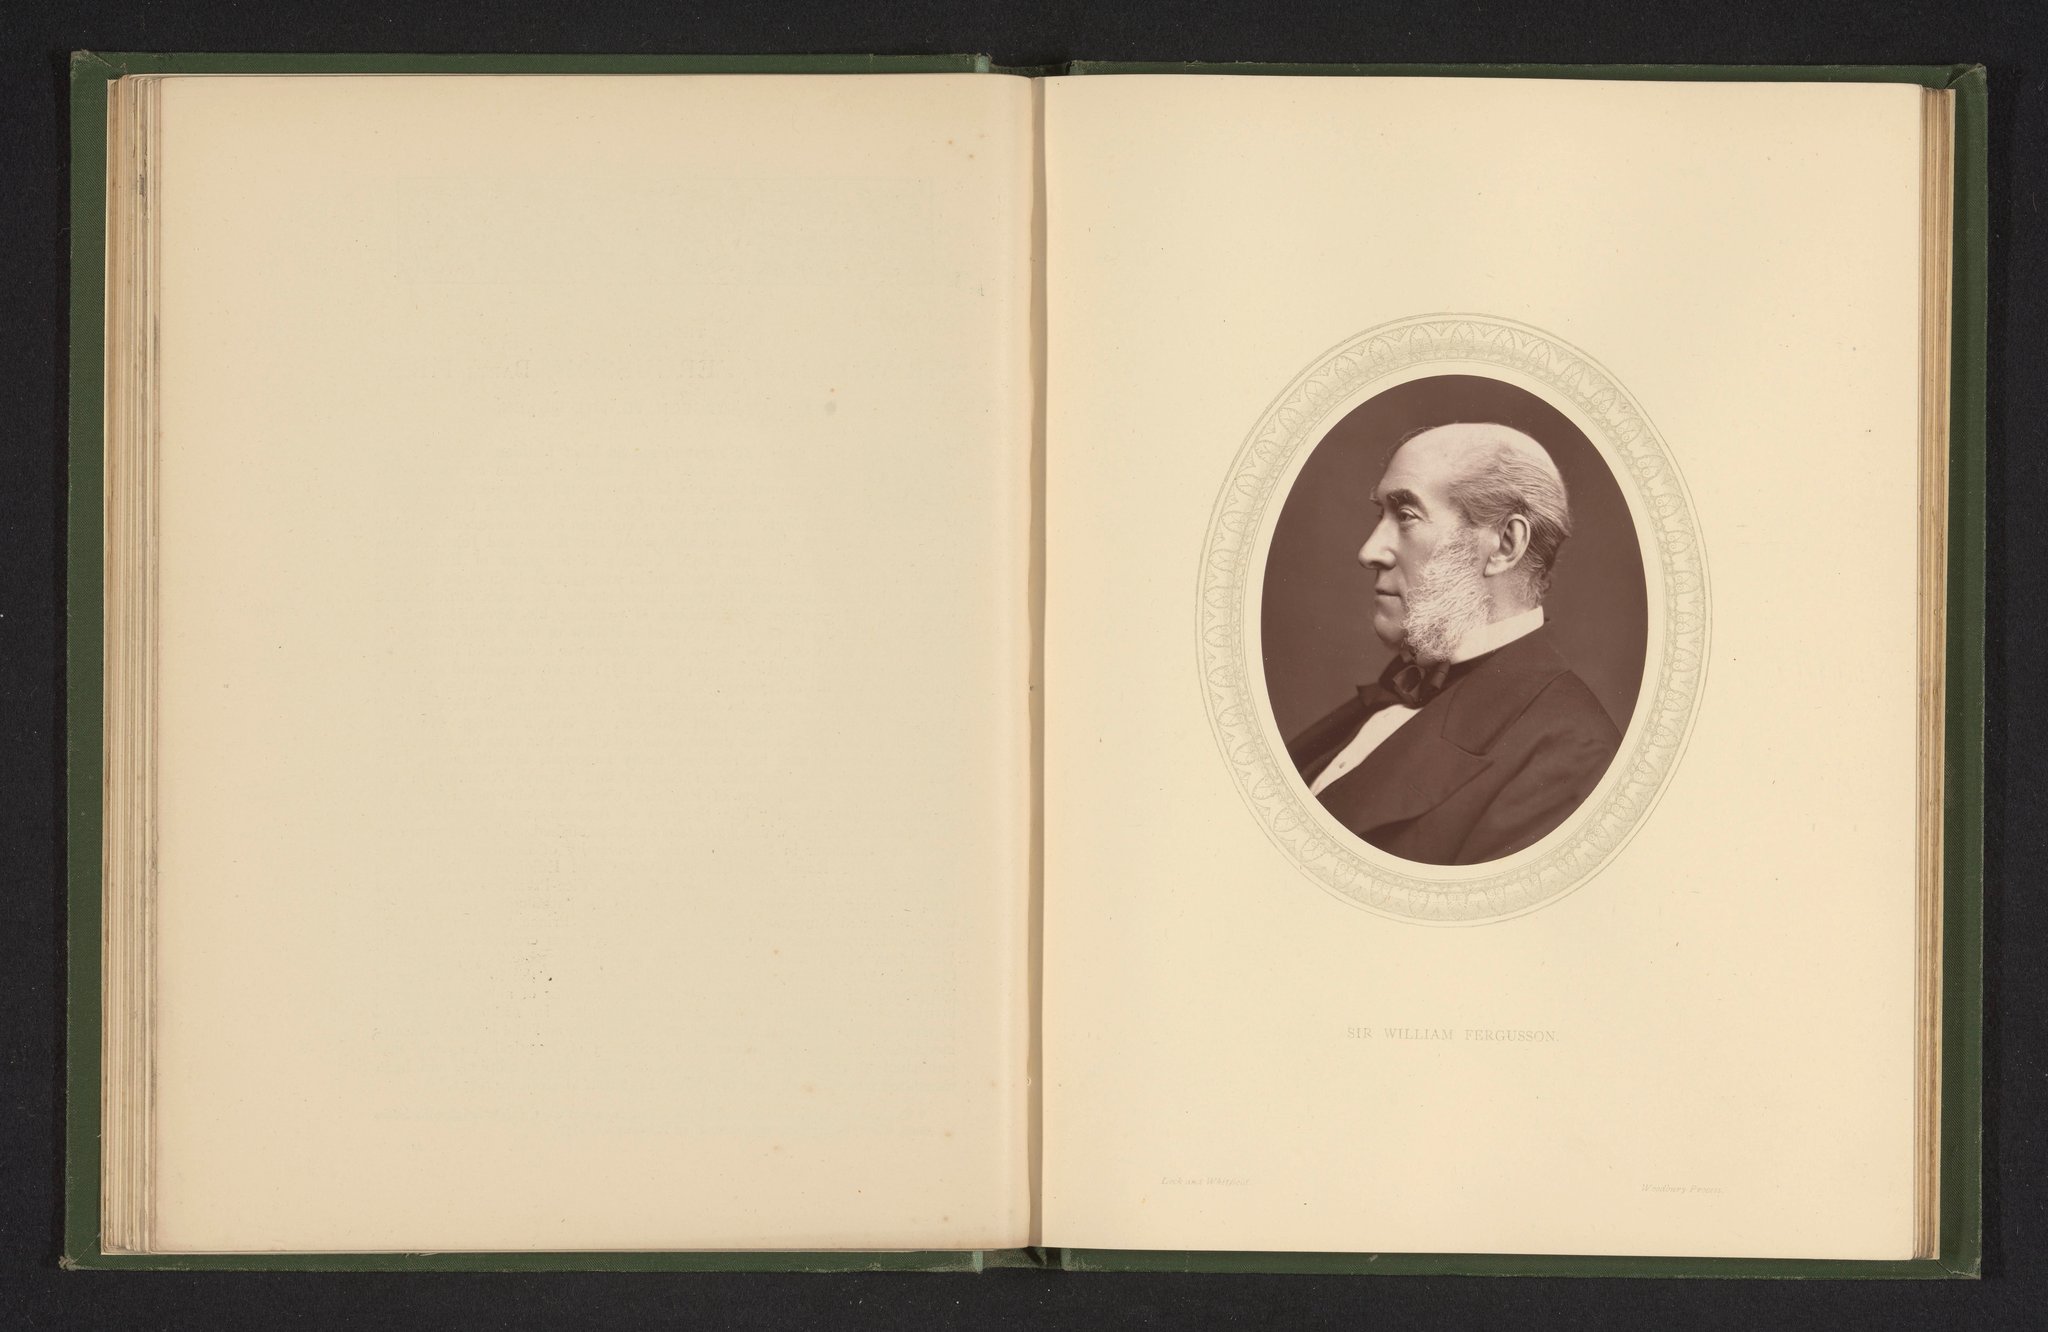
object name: page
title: Sir William Fergusson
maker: Anonymous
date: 1872-1877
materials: paper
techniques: woodburytype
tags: barber; surgeon, historical persons (portraits and scenes from the life) (+ (full) bust portrait)